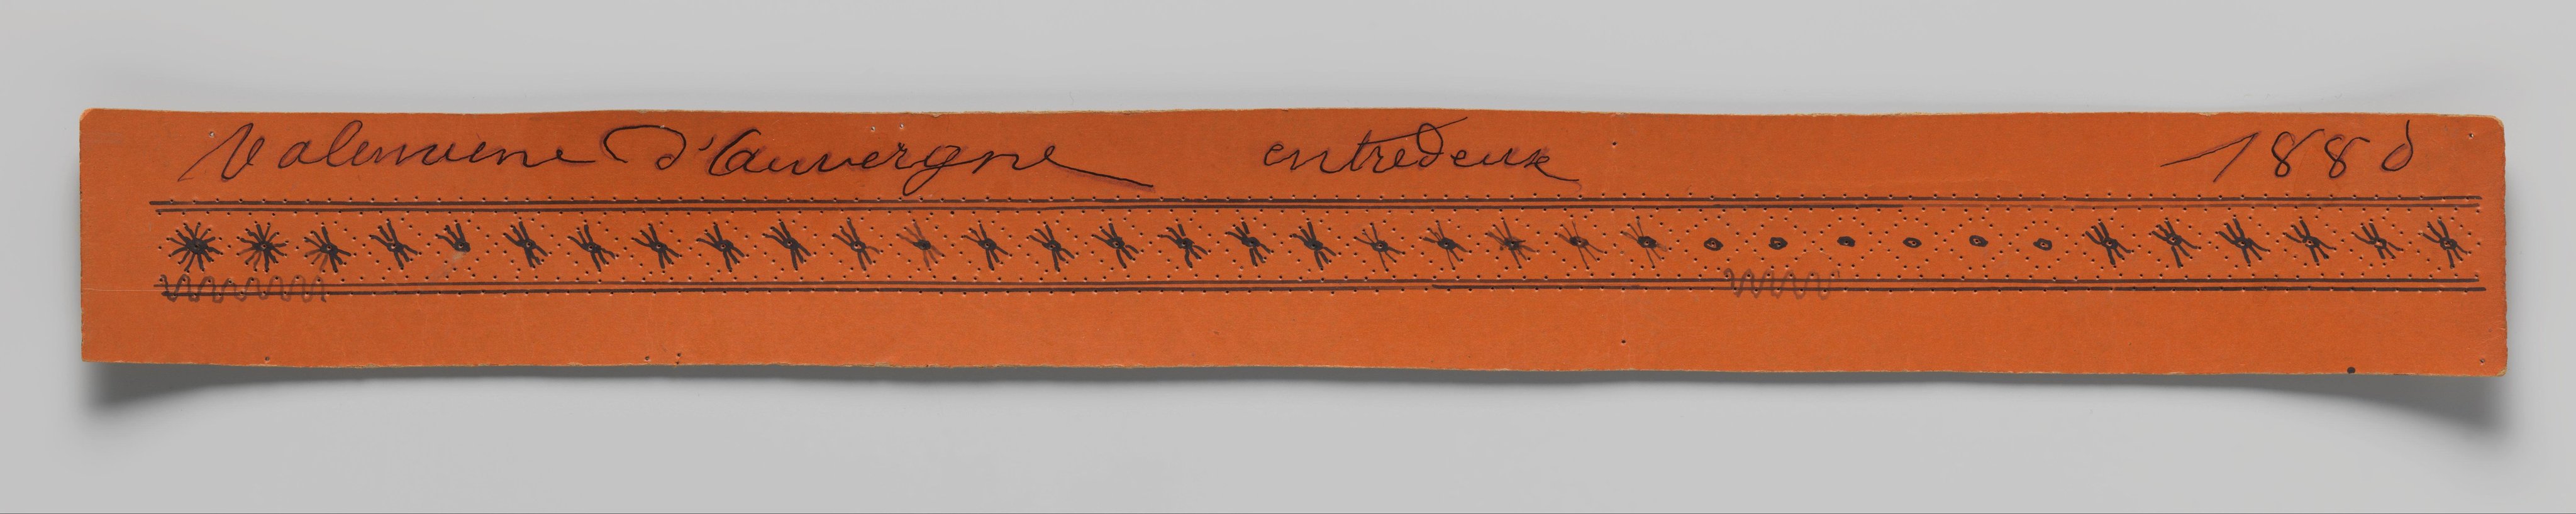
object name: lace pattern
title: Patroon voor een tussenzetsel van kloskant Valenciennes d'Auvergne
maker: Anonymous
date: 1880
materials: cardboard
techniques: drawing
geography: france